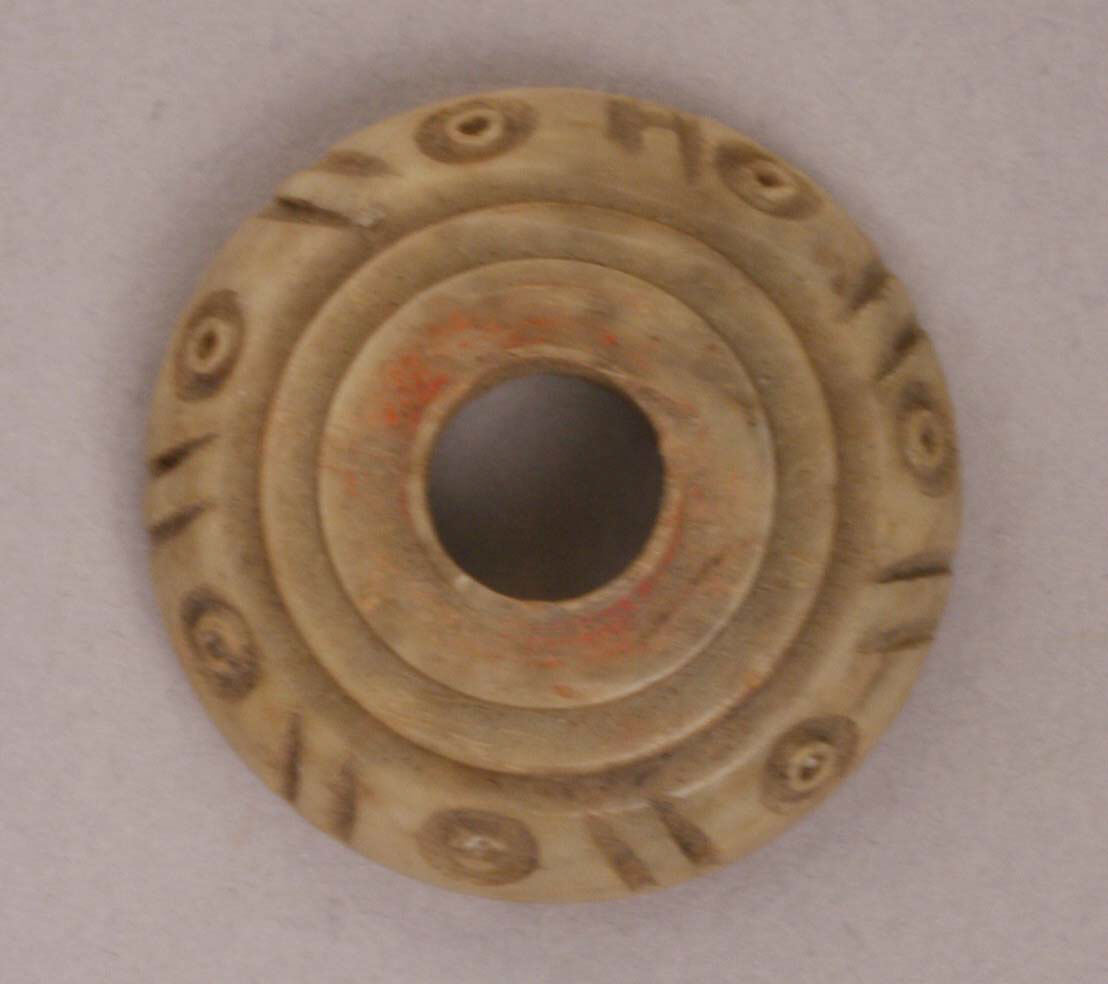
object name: button or bead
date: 801-1000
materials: bone, paint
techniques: incising, inlay, tinting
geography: iran